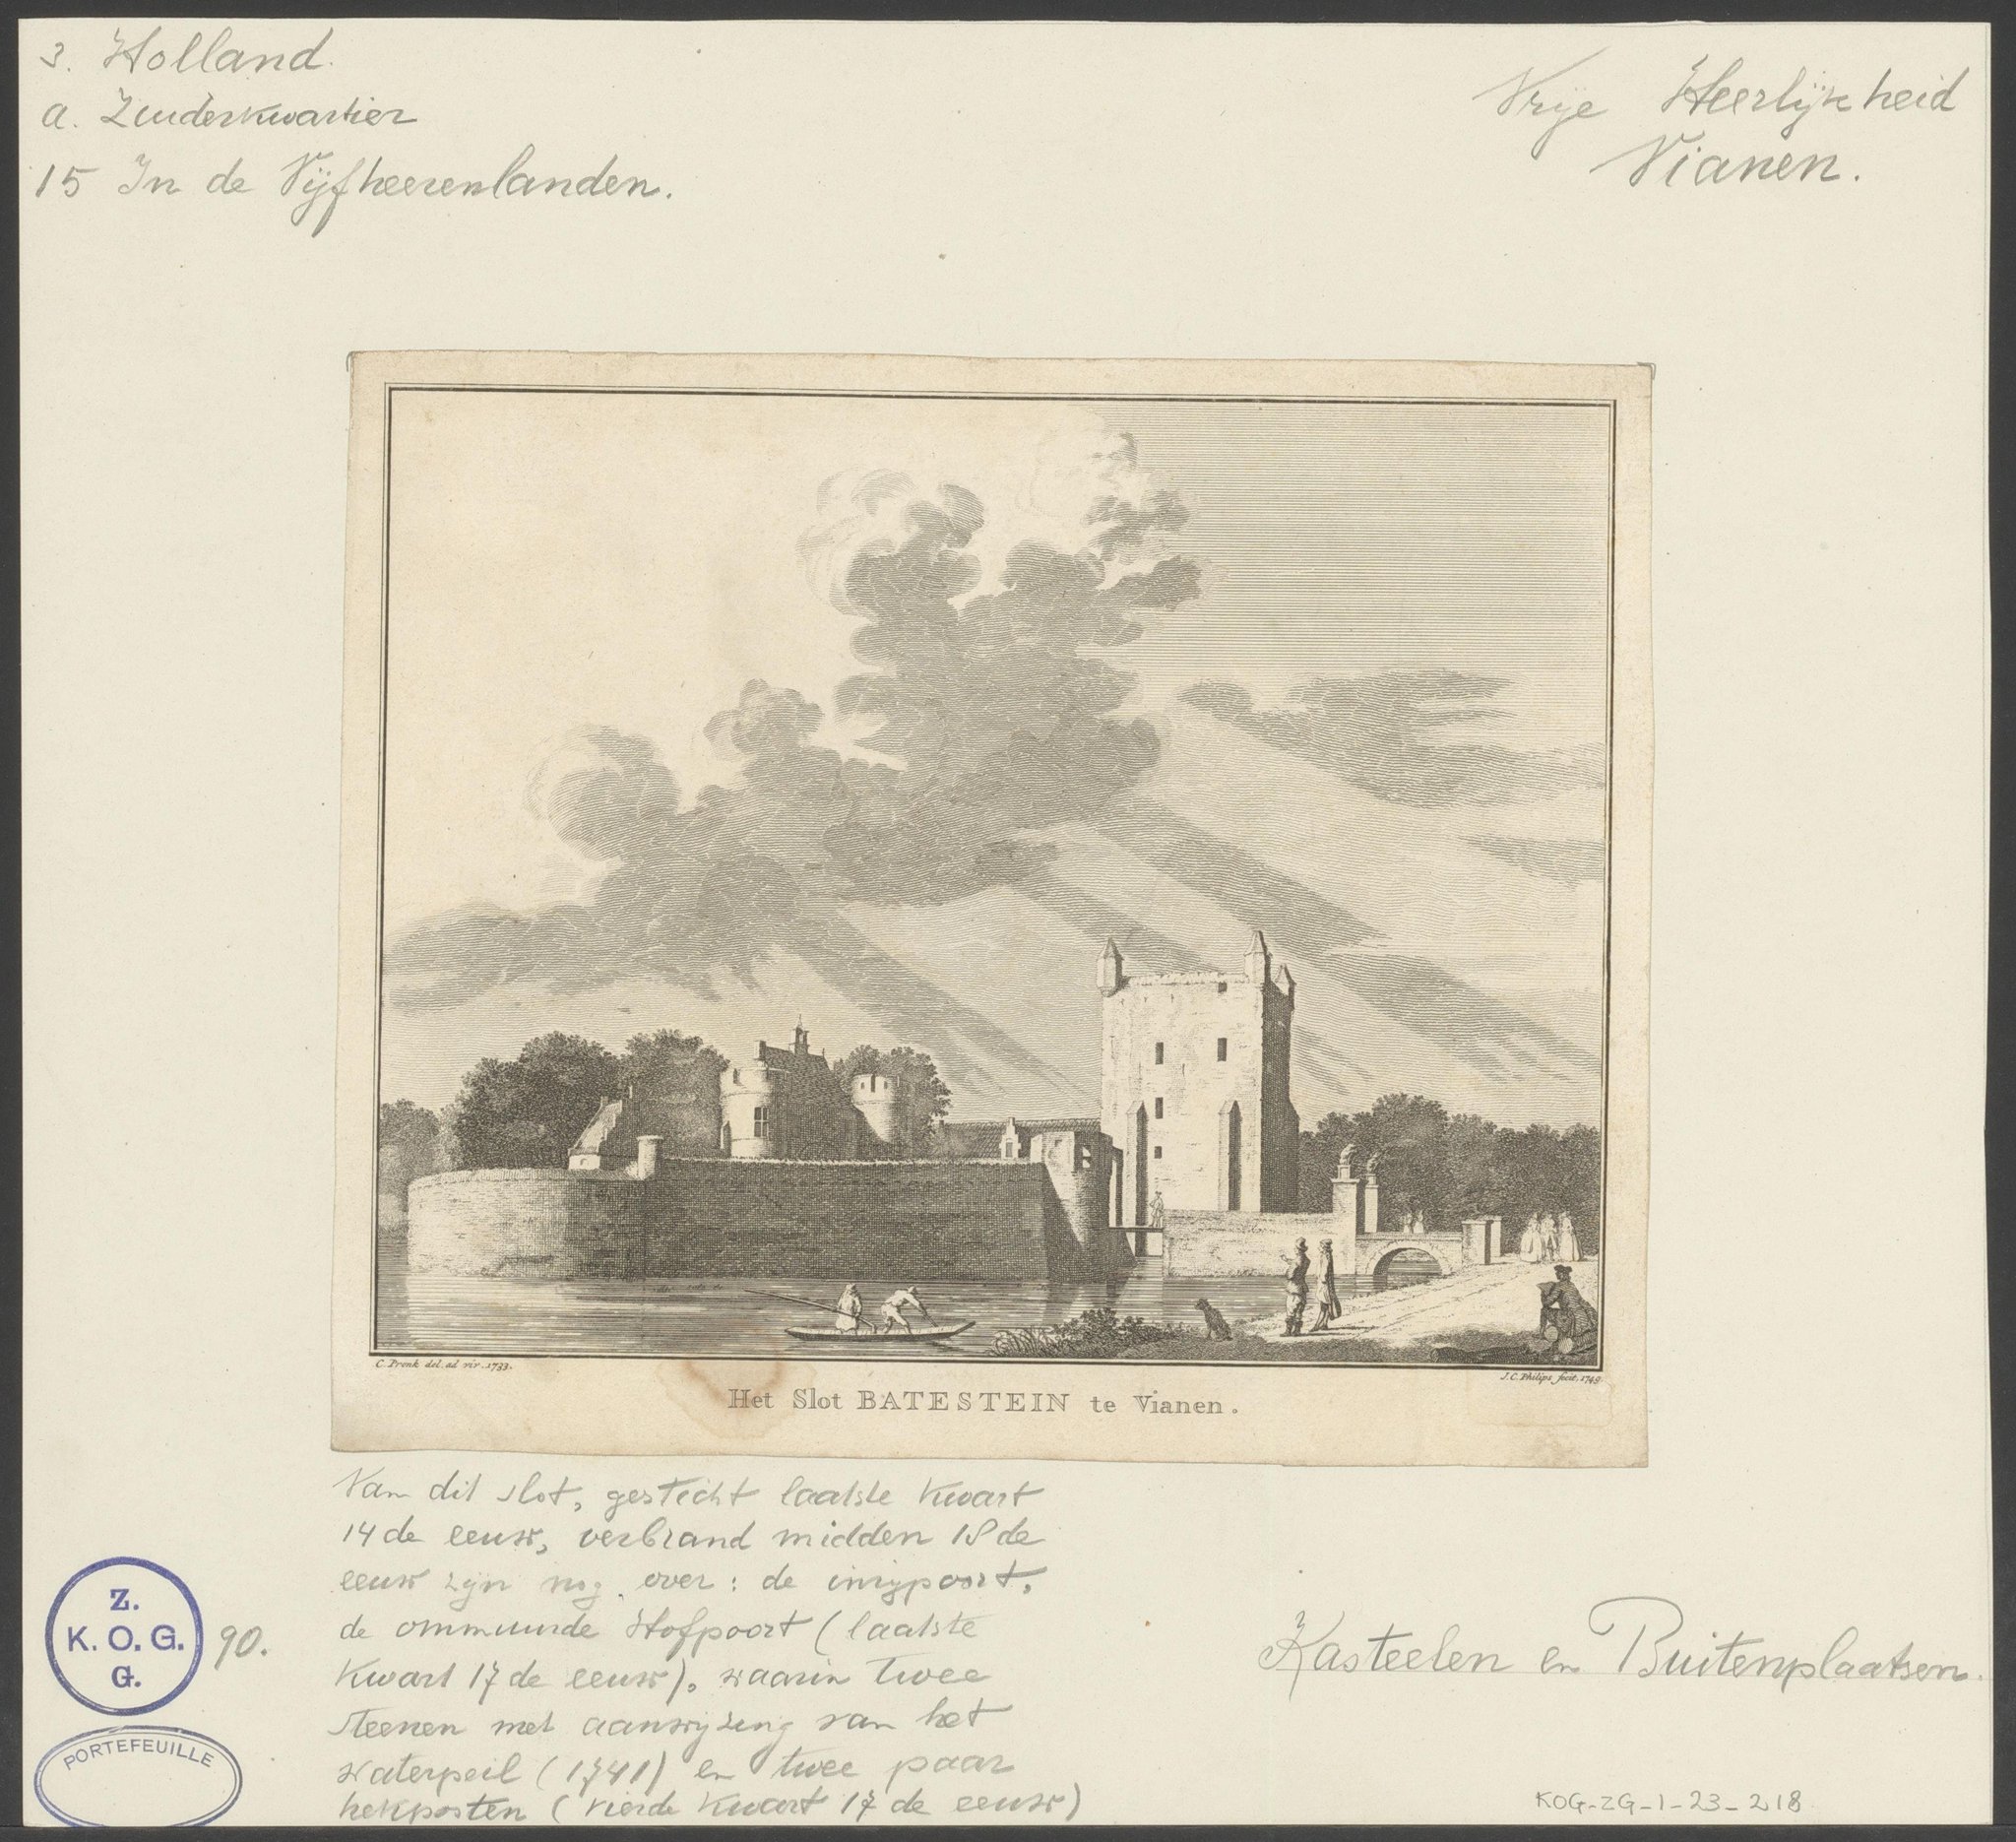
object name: print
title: Gezicht op Kasteel Batestein, 1733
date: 1749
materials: paper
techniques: etching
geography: vianen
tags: castle, rowing-boat, canoe, etc.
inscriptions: stamp, collector's mark: Lugt 1641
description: Gezicht op Kasteel Batestein te Vianen, in de situatie omstreeks 1733. Op de voorgrond twee mannen in een roeiboot op de slotgracht. Onderwerpsrubrieken binnen de Atlas Zeden en Gewoonten: Zeden en gewoonten in Engeren zin, De woning, Kastelen en buitenplaatsen.